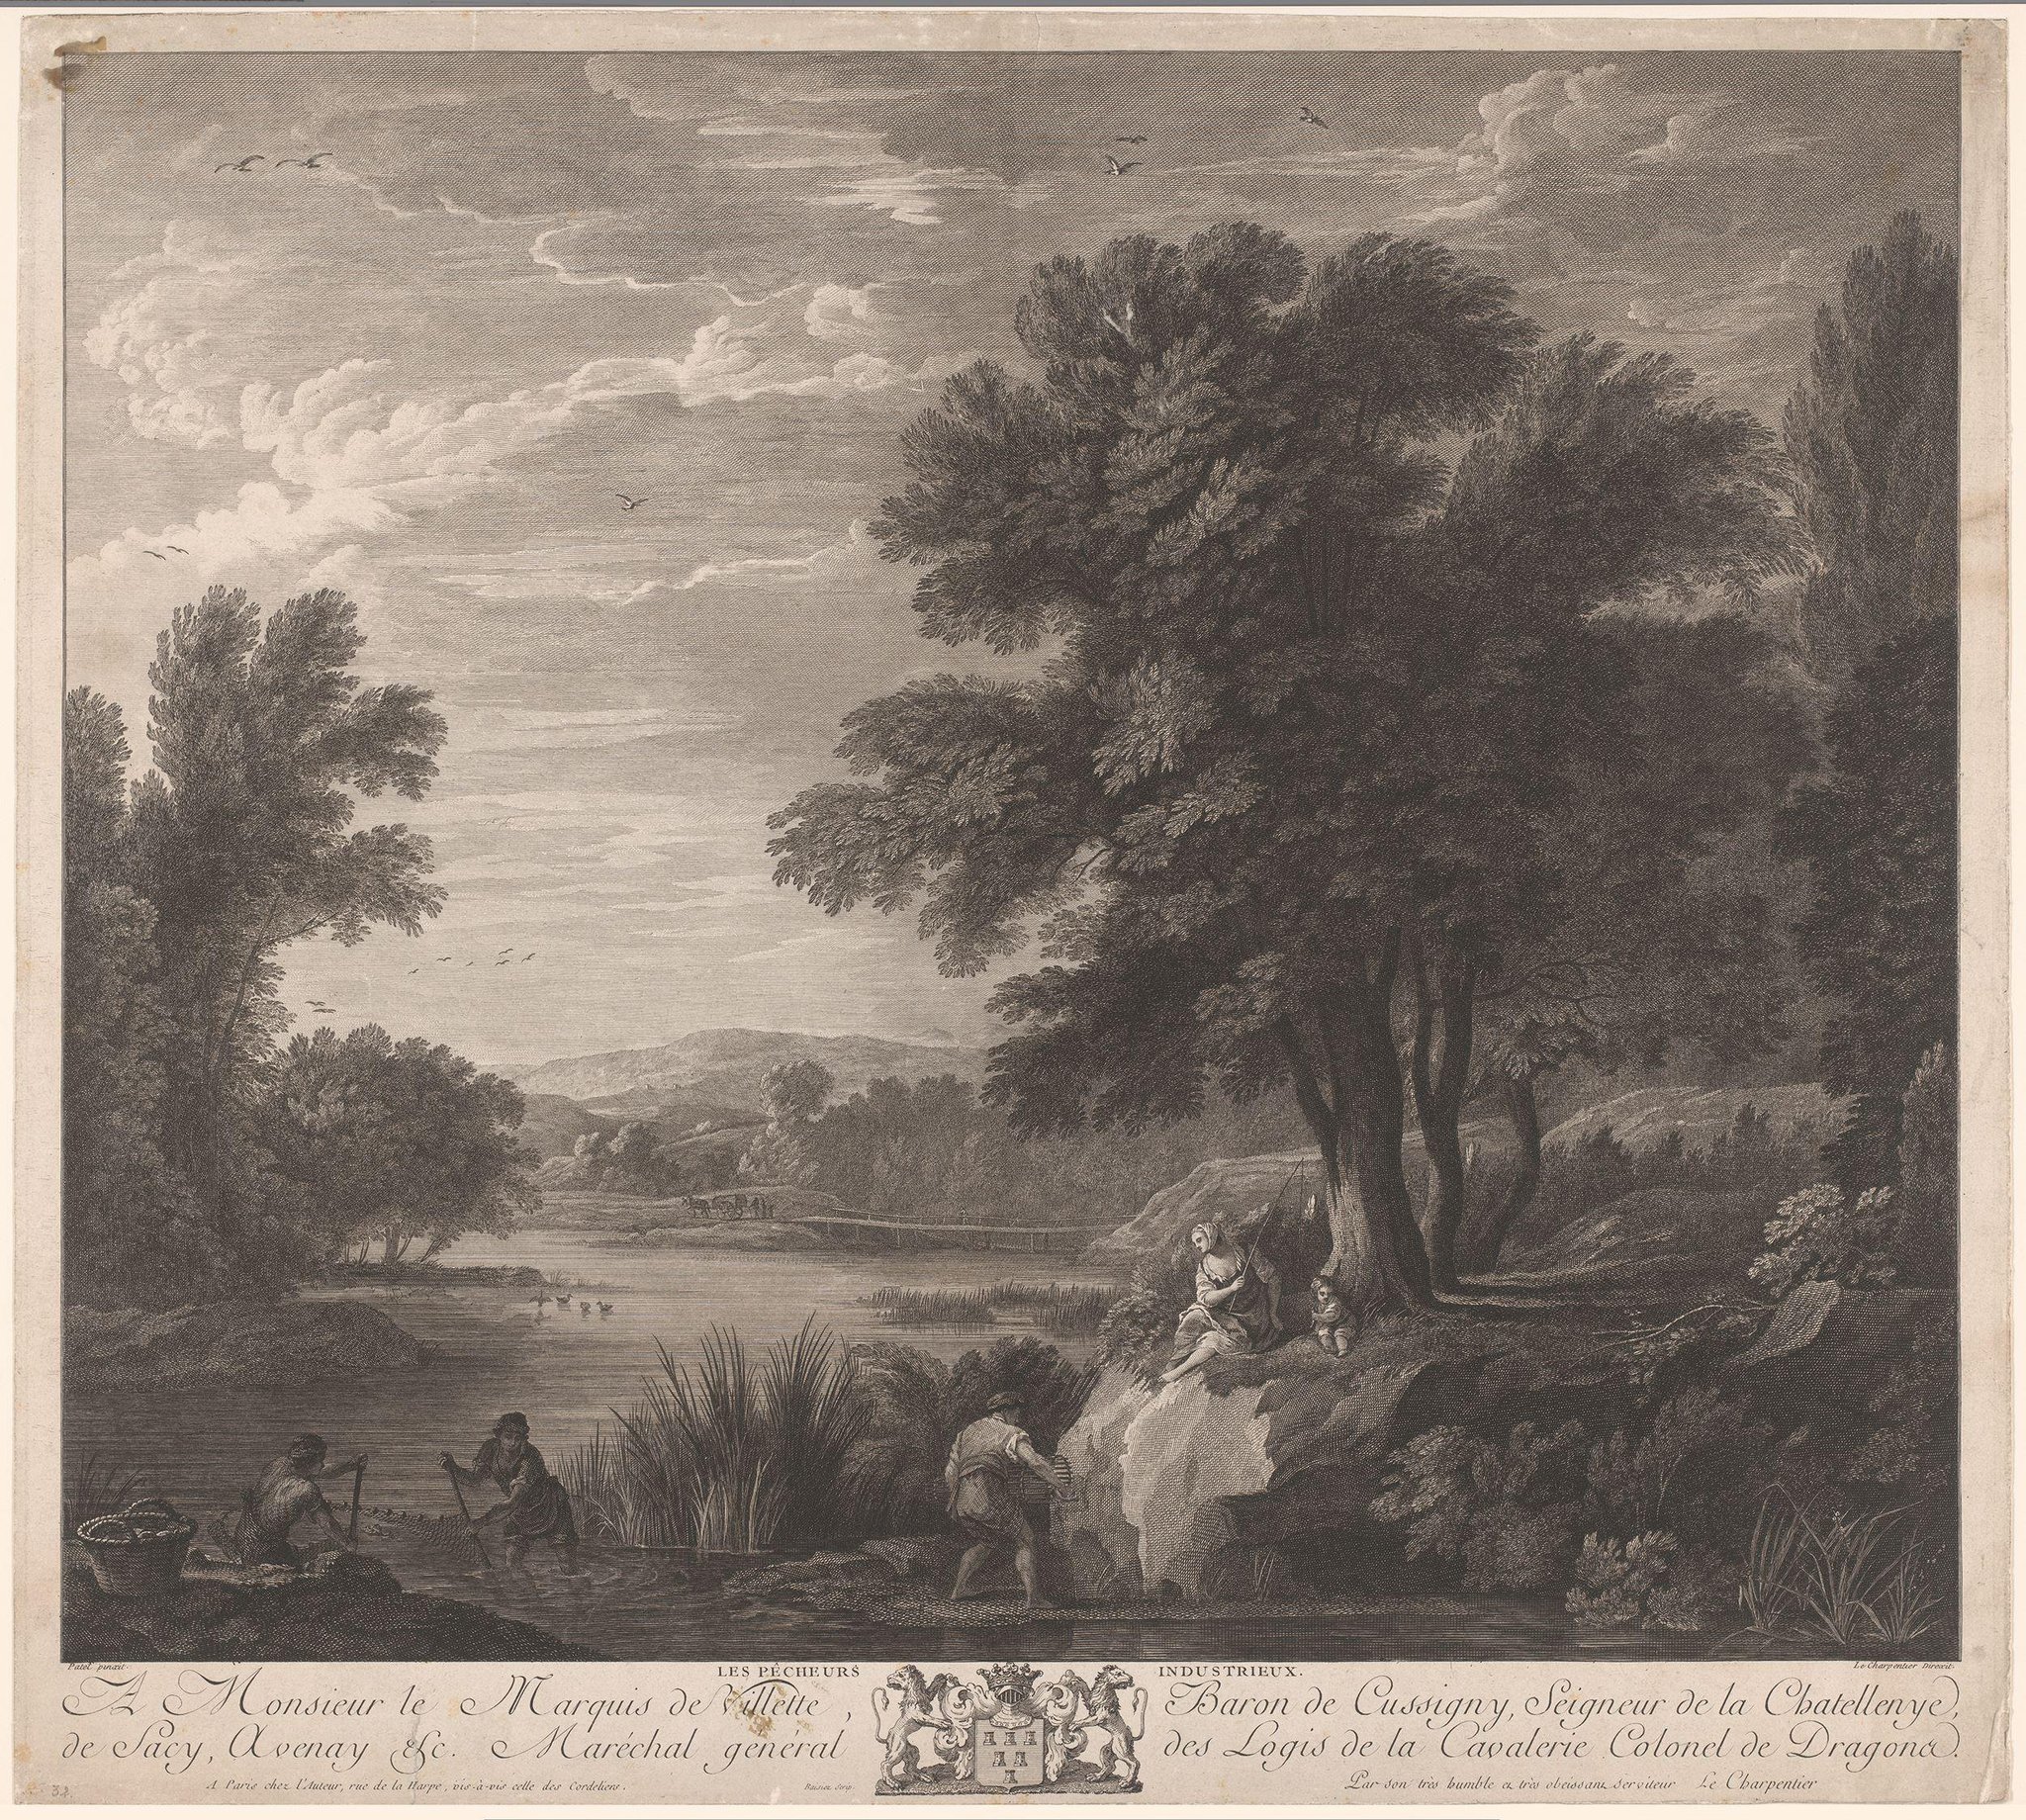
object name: print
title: Landschap met vissers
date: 1743-1770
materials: paper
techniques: engraving, etching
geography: paris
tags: landscapes with waters, waterscapes, seascapes (in the temperate zone), fisherman, armorial bearing, heraldry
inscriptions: collector's mark: Lugt 2228